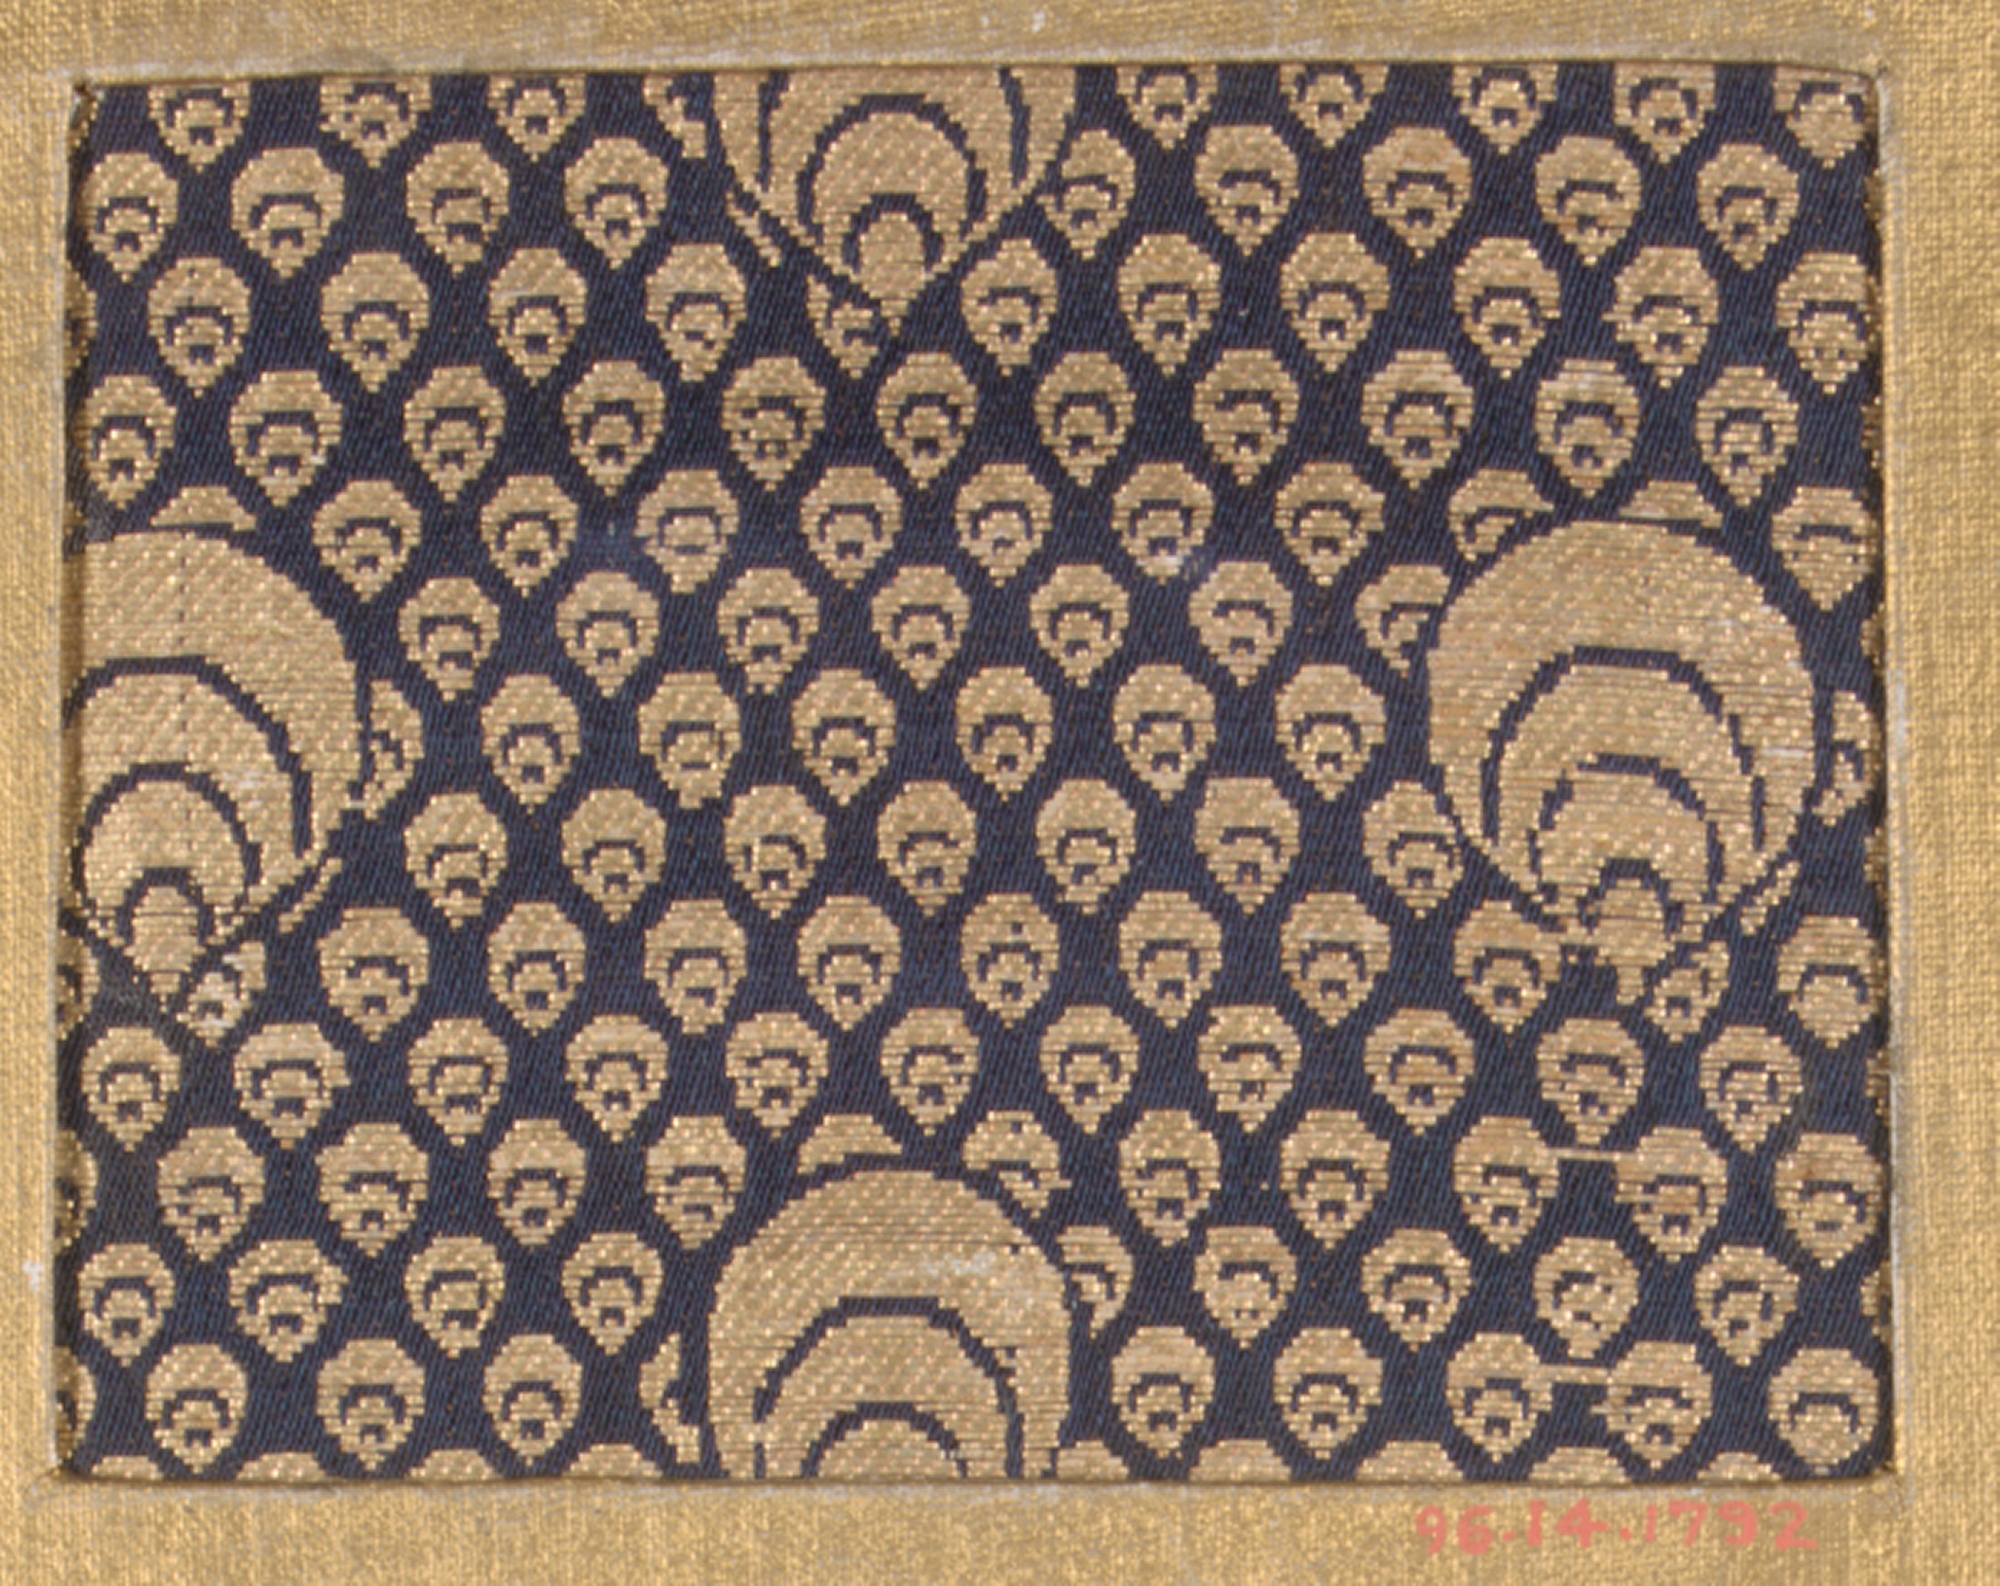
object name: piece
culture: japanese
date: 1701-1900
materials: metal thread, silk